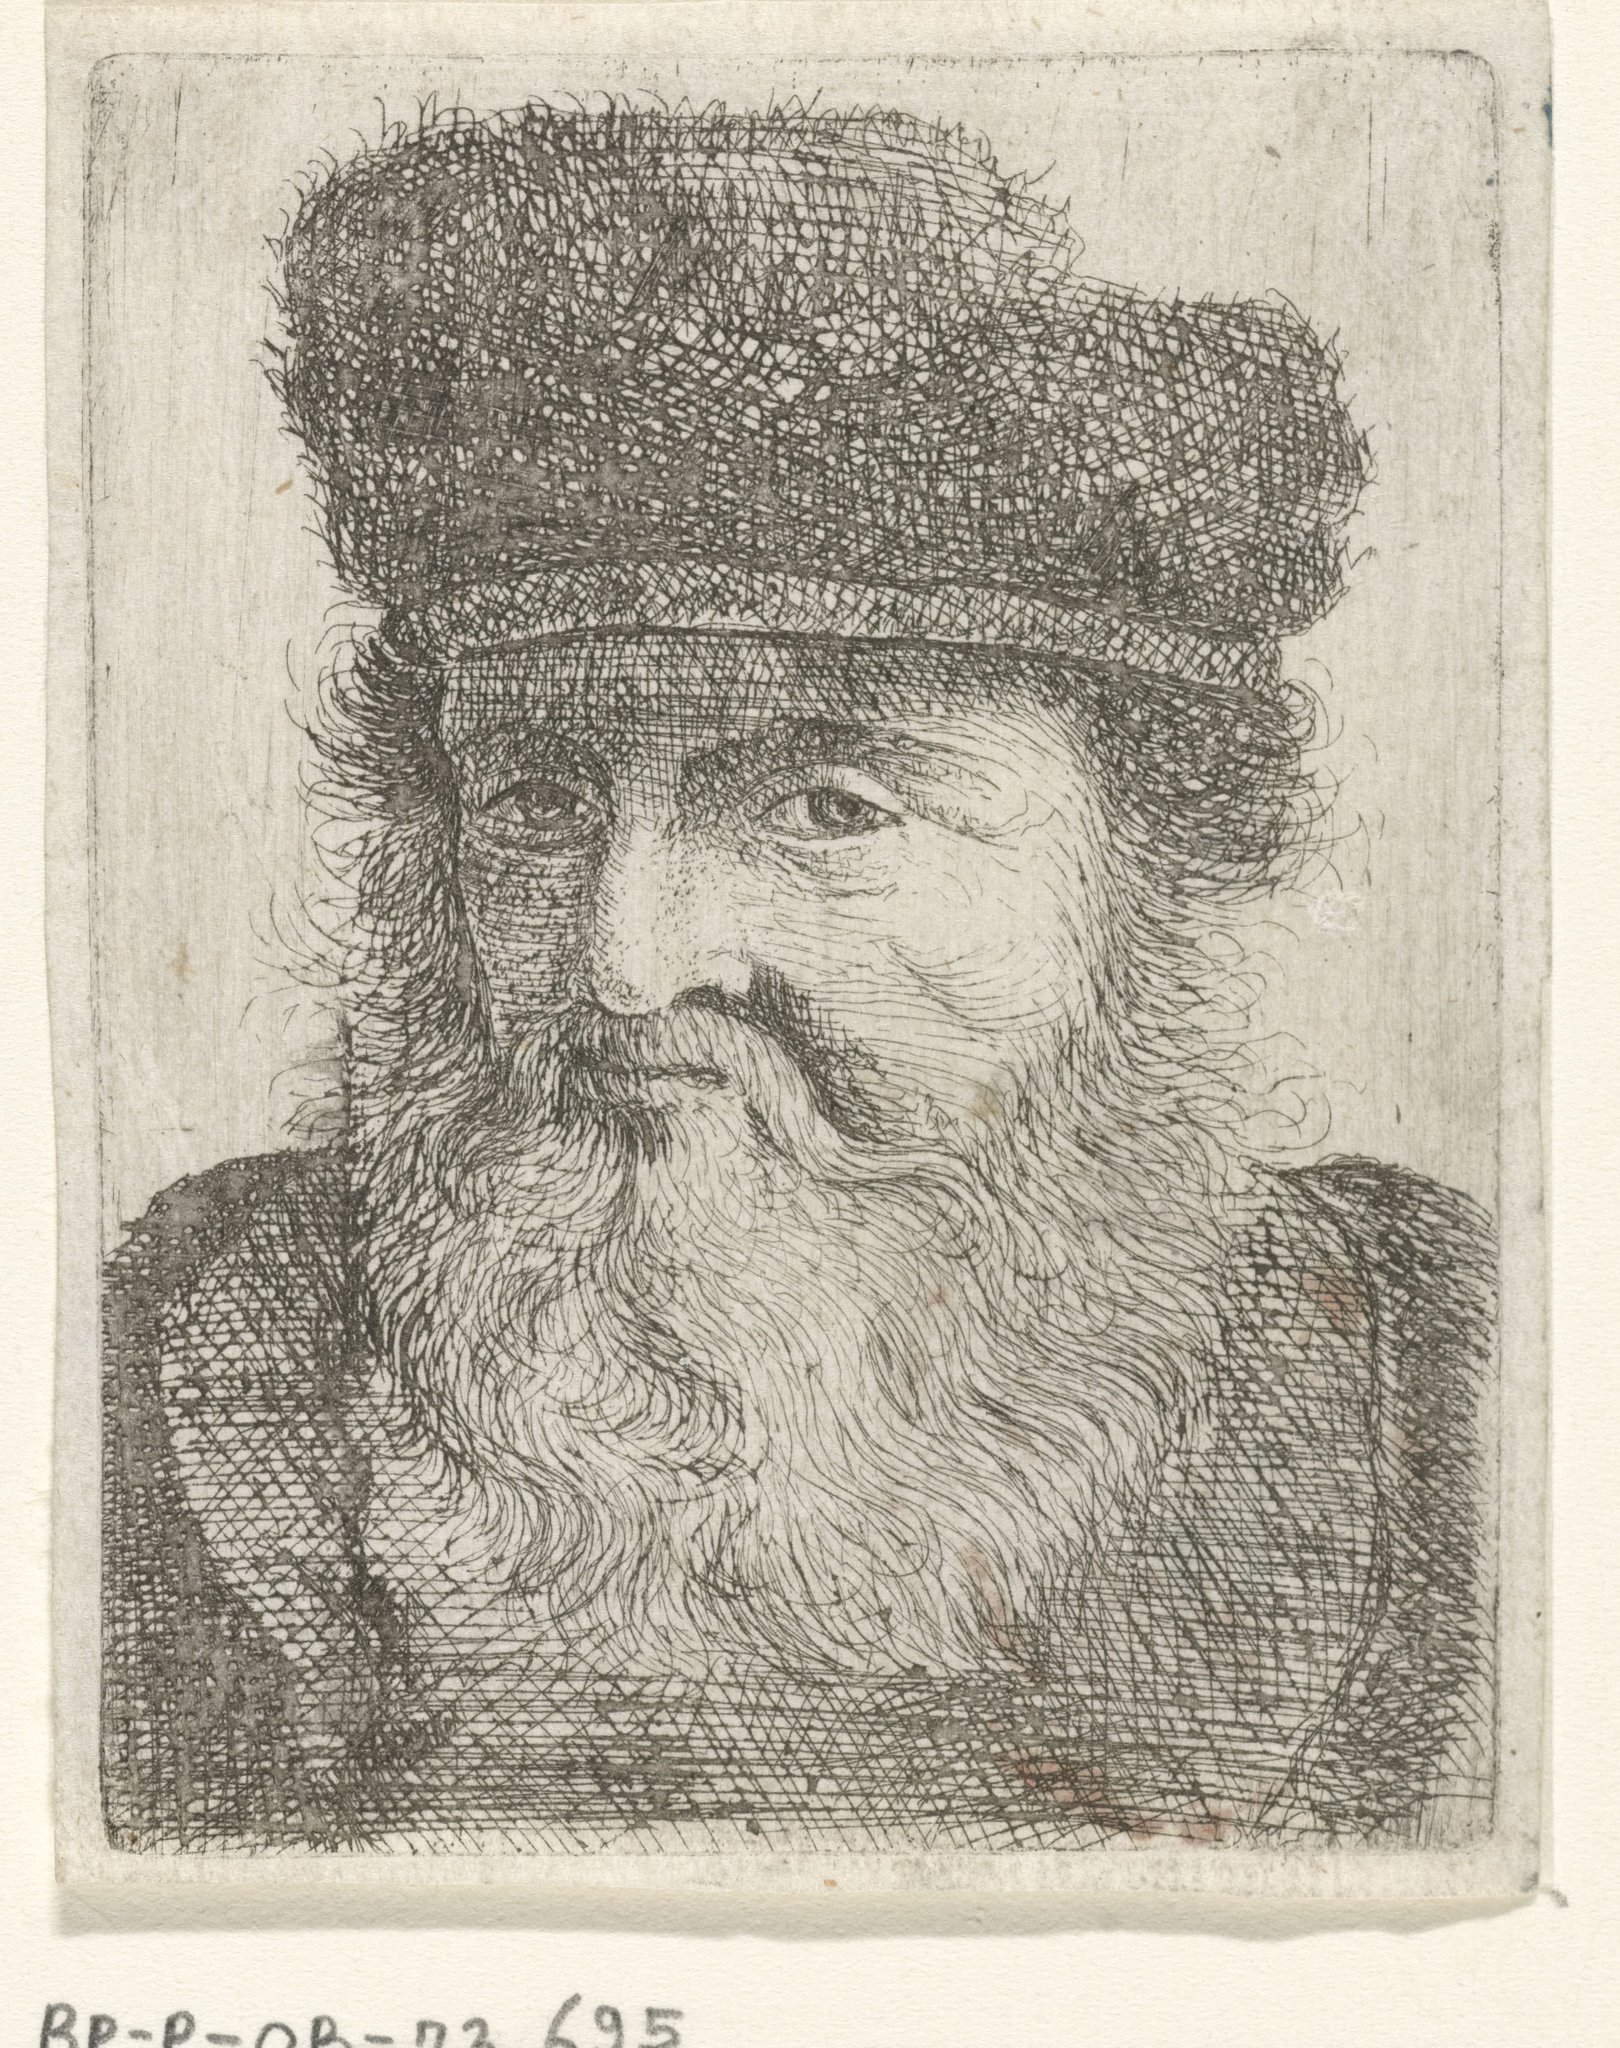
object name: print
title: Old man with beard, fur cap, and velvet cloak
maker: Anonymous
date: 1631-1719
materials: paper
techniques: etching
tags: head-gear (with name)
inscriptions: collector's mark: Lugt 232, collector's mark: Lugt 240